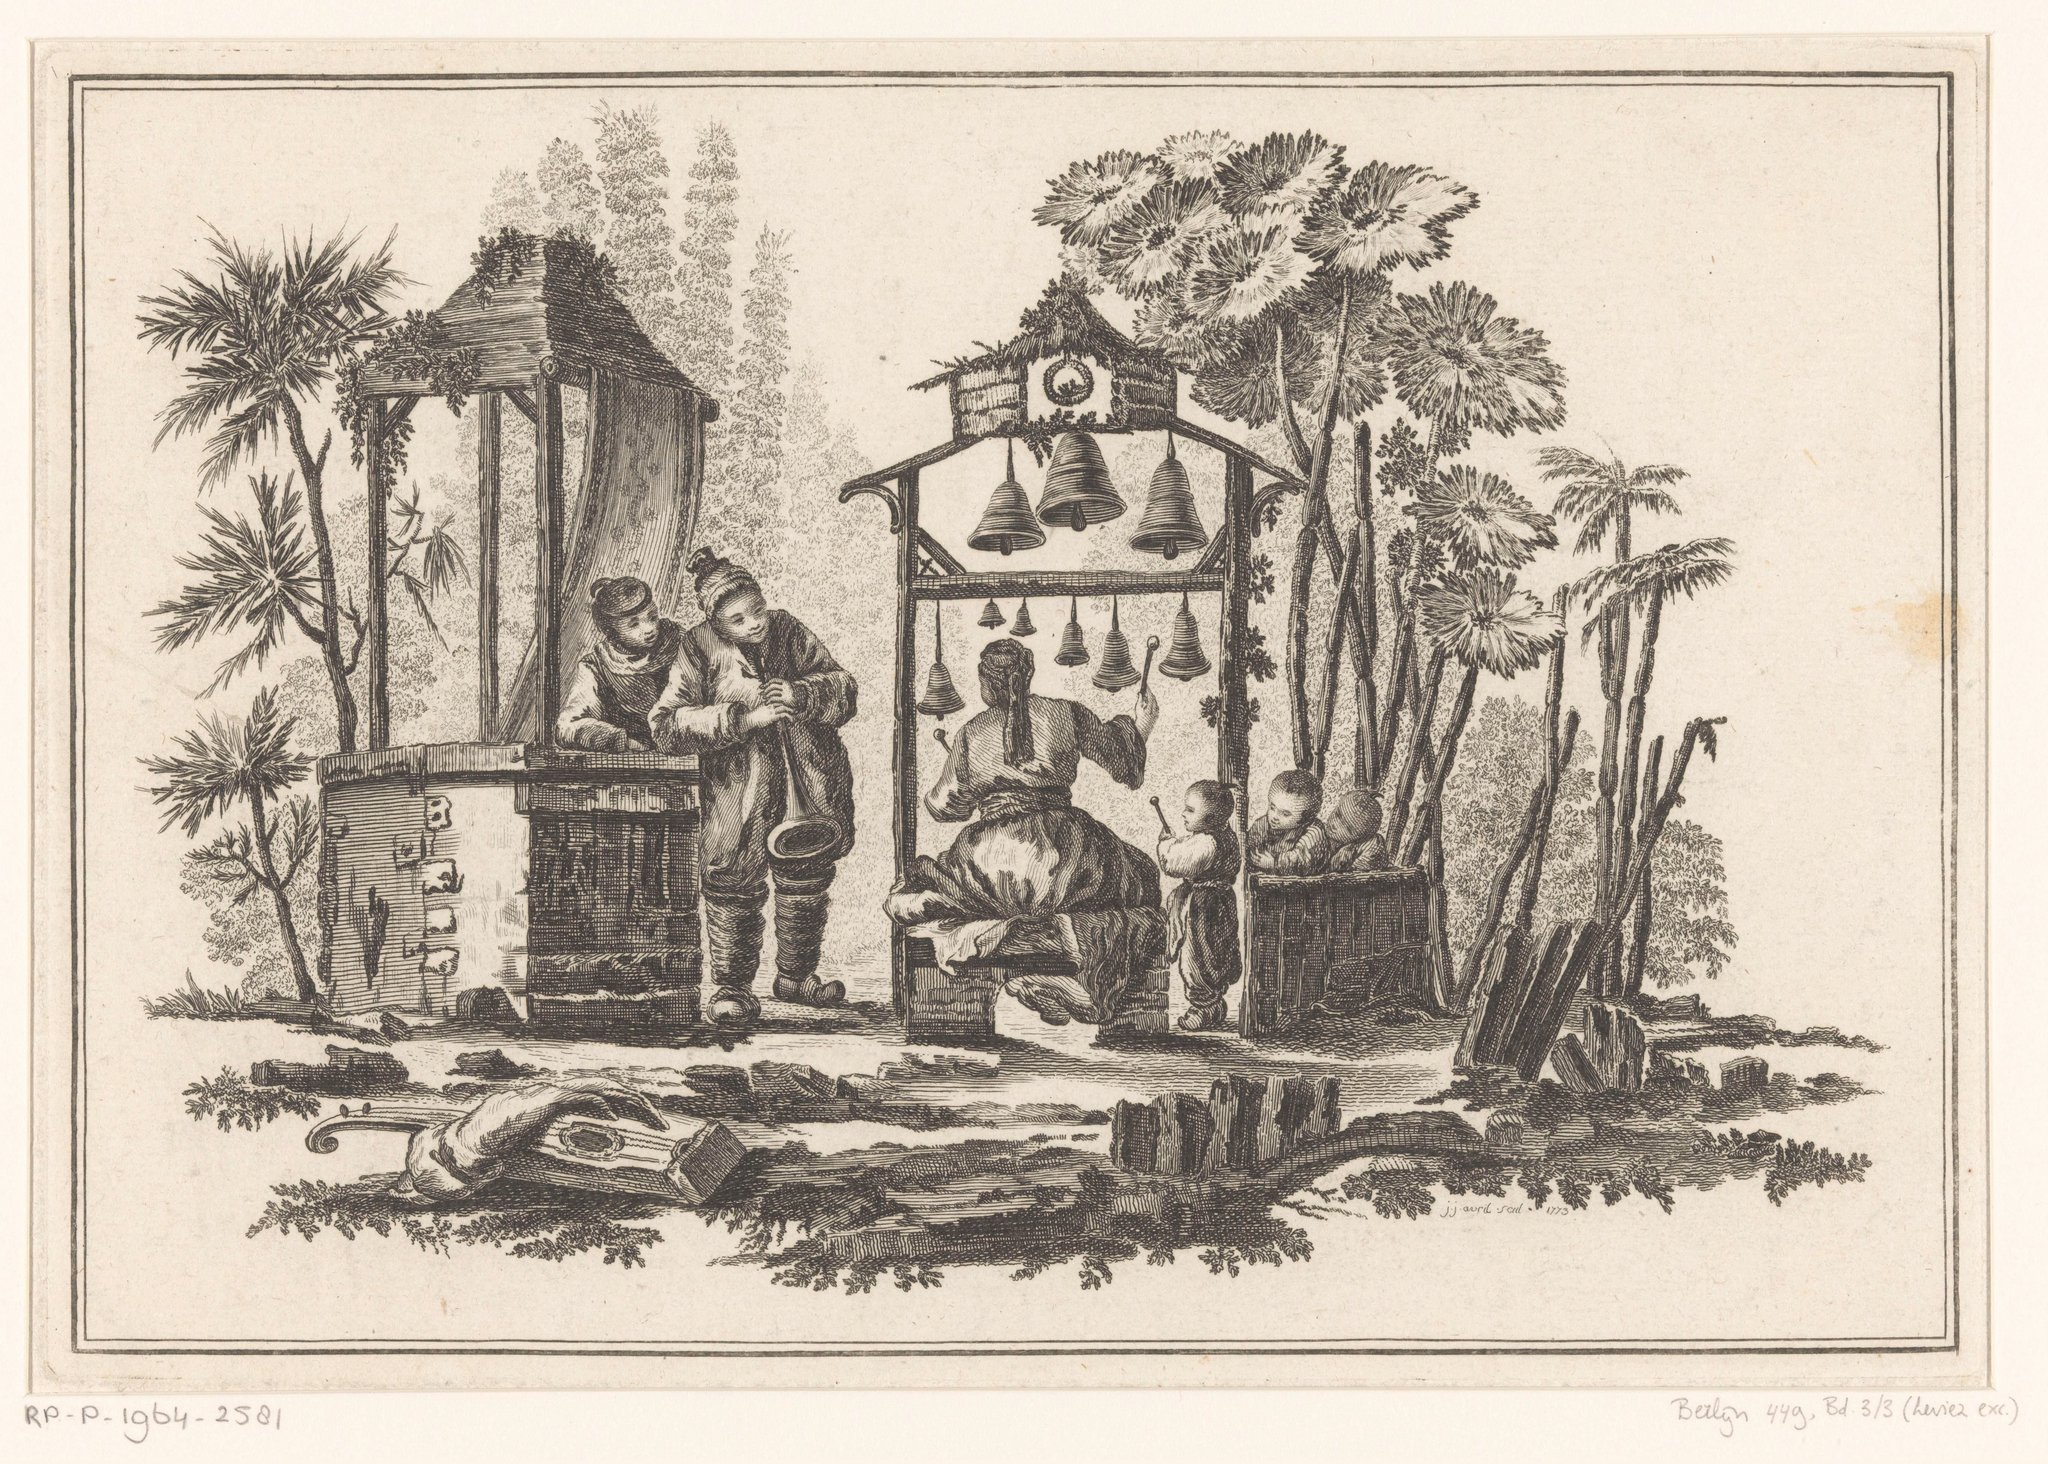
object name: print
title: Gehoor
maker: jean jacques avril (i)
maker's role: print maker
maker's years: 1744-1831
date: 1773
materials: paper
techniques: etching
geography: paris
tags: hearing, listening (one of the five senses)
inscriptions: collector's mark: Lugt 2760, collector's mark: Lugt 2228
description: Personificatie van het zintuig het gehoor. Rechts zit een figuur op de rug gezien en speelt op een stellage met bellen, drie kinderen en twee figuren links kijken toe. Eén van de twee figuren links heeft een blaasinstrument vast. Op de voorgrond in het landschap ligt een snaarinstrument.